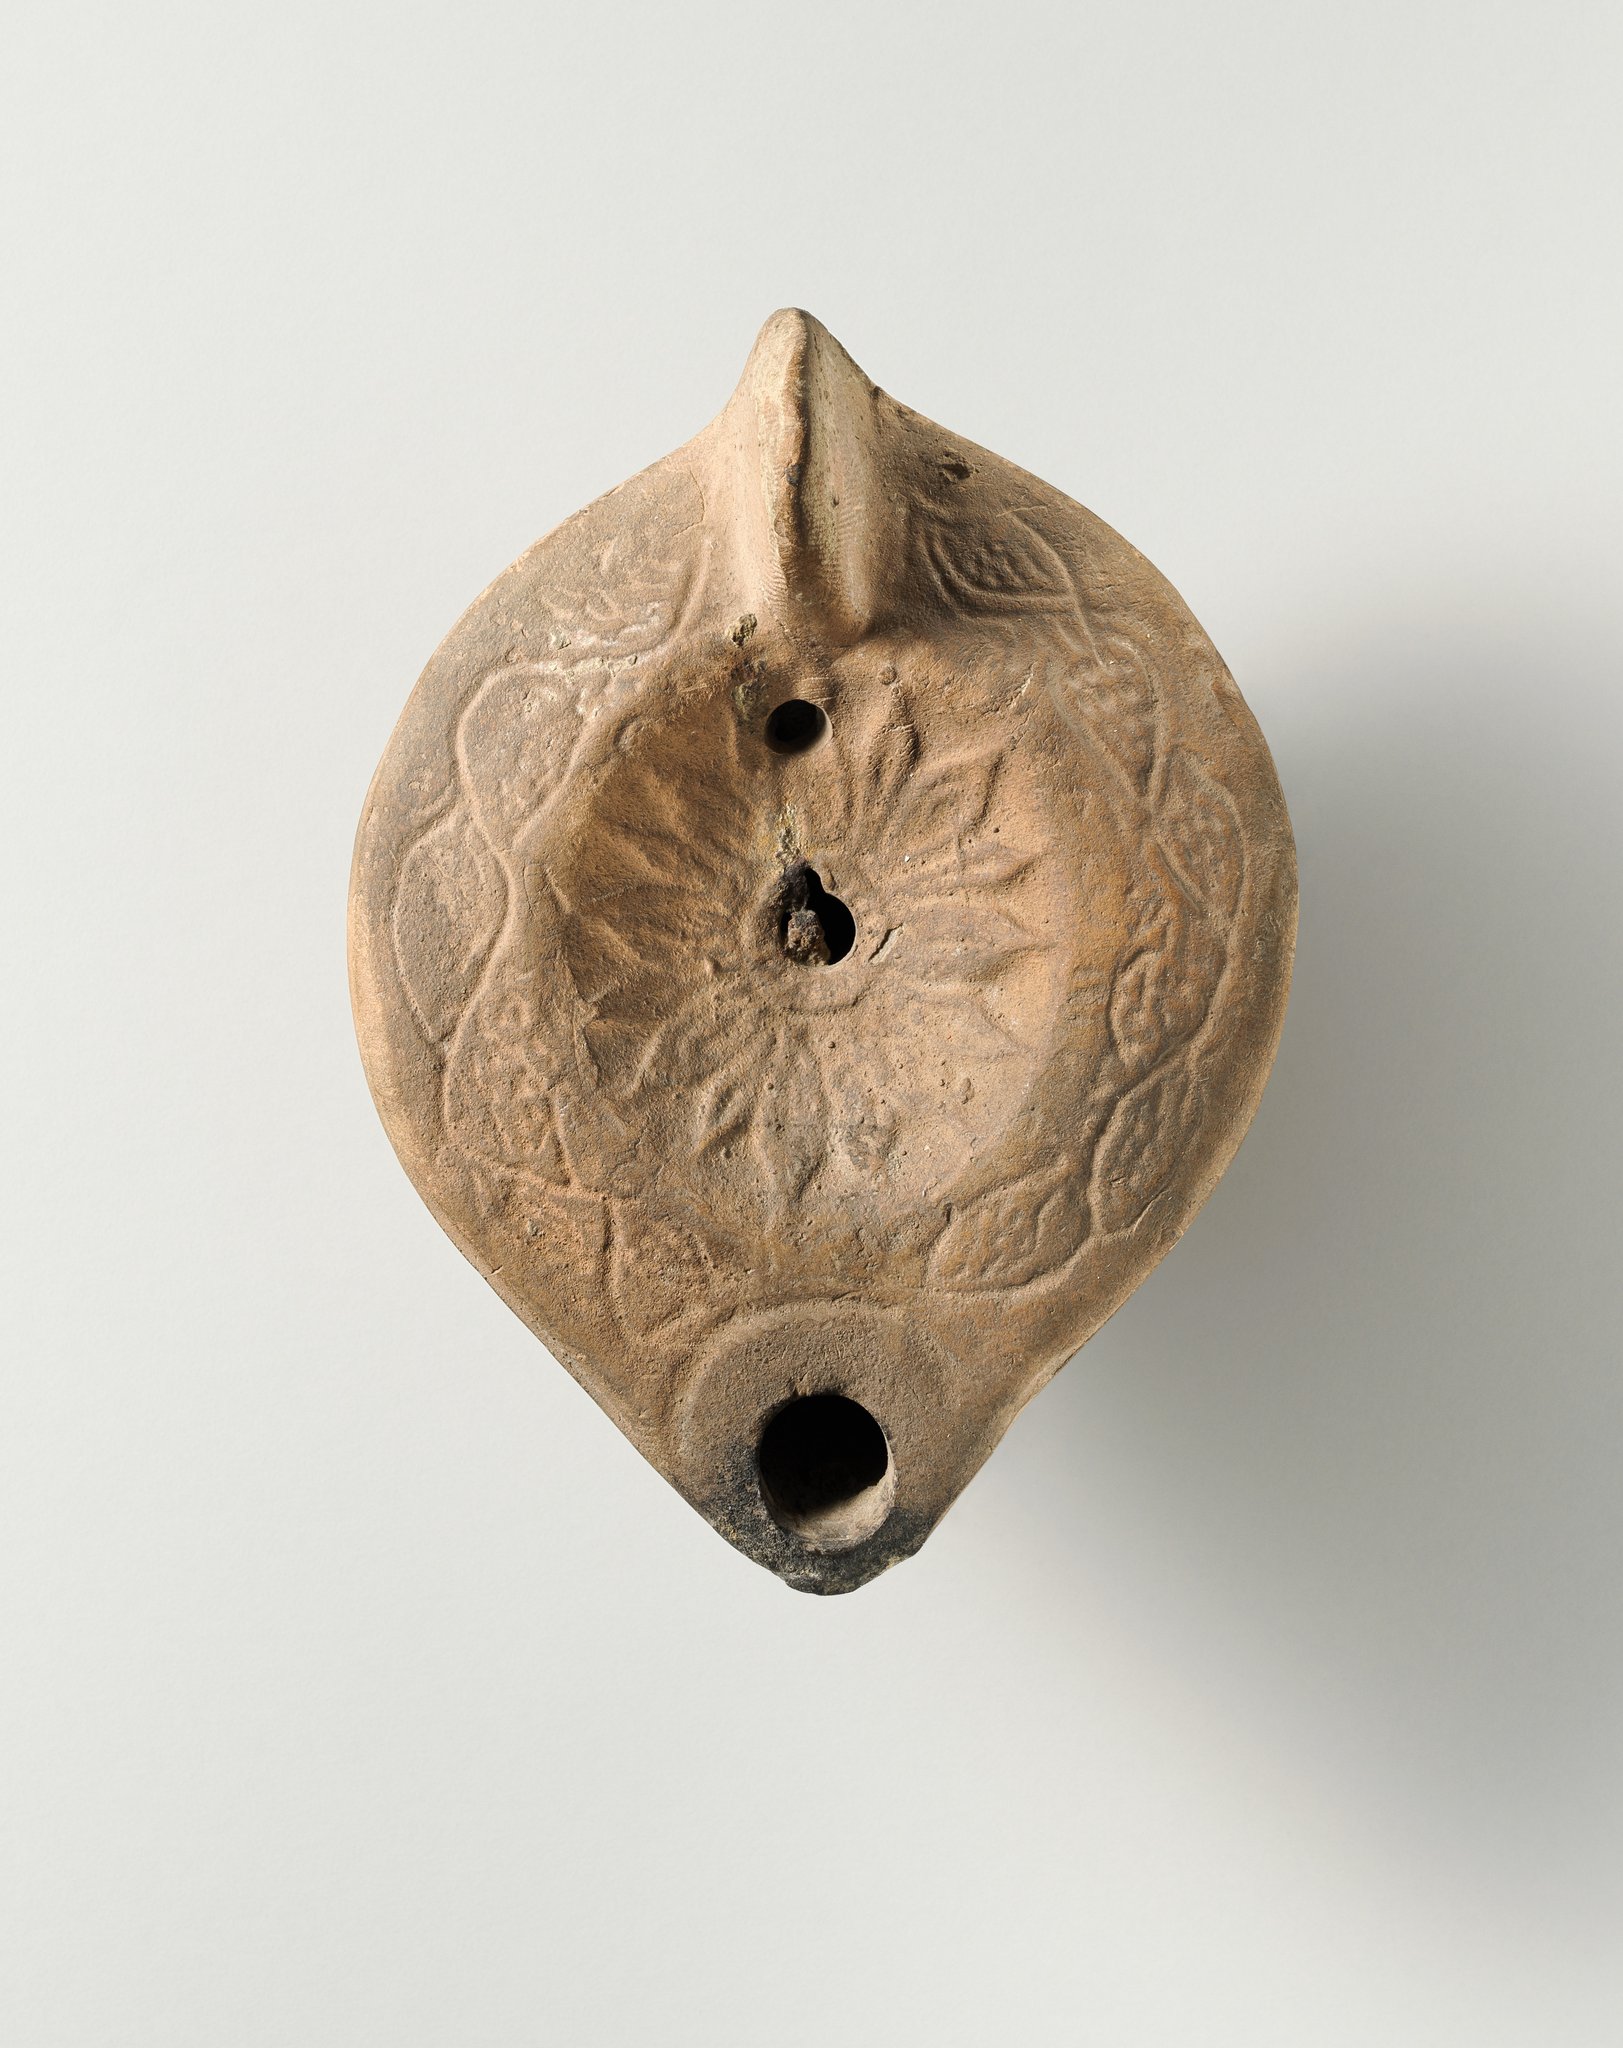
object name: lamp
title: Terracotta oil lamp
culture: roman, cypriot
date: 200-350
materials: terracotta